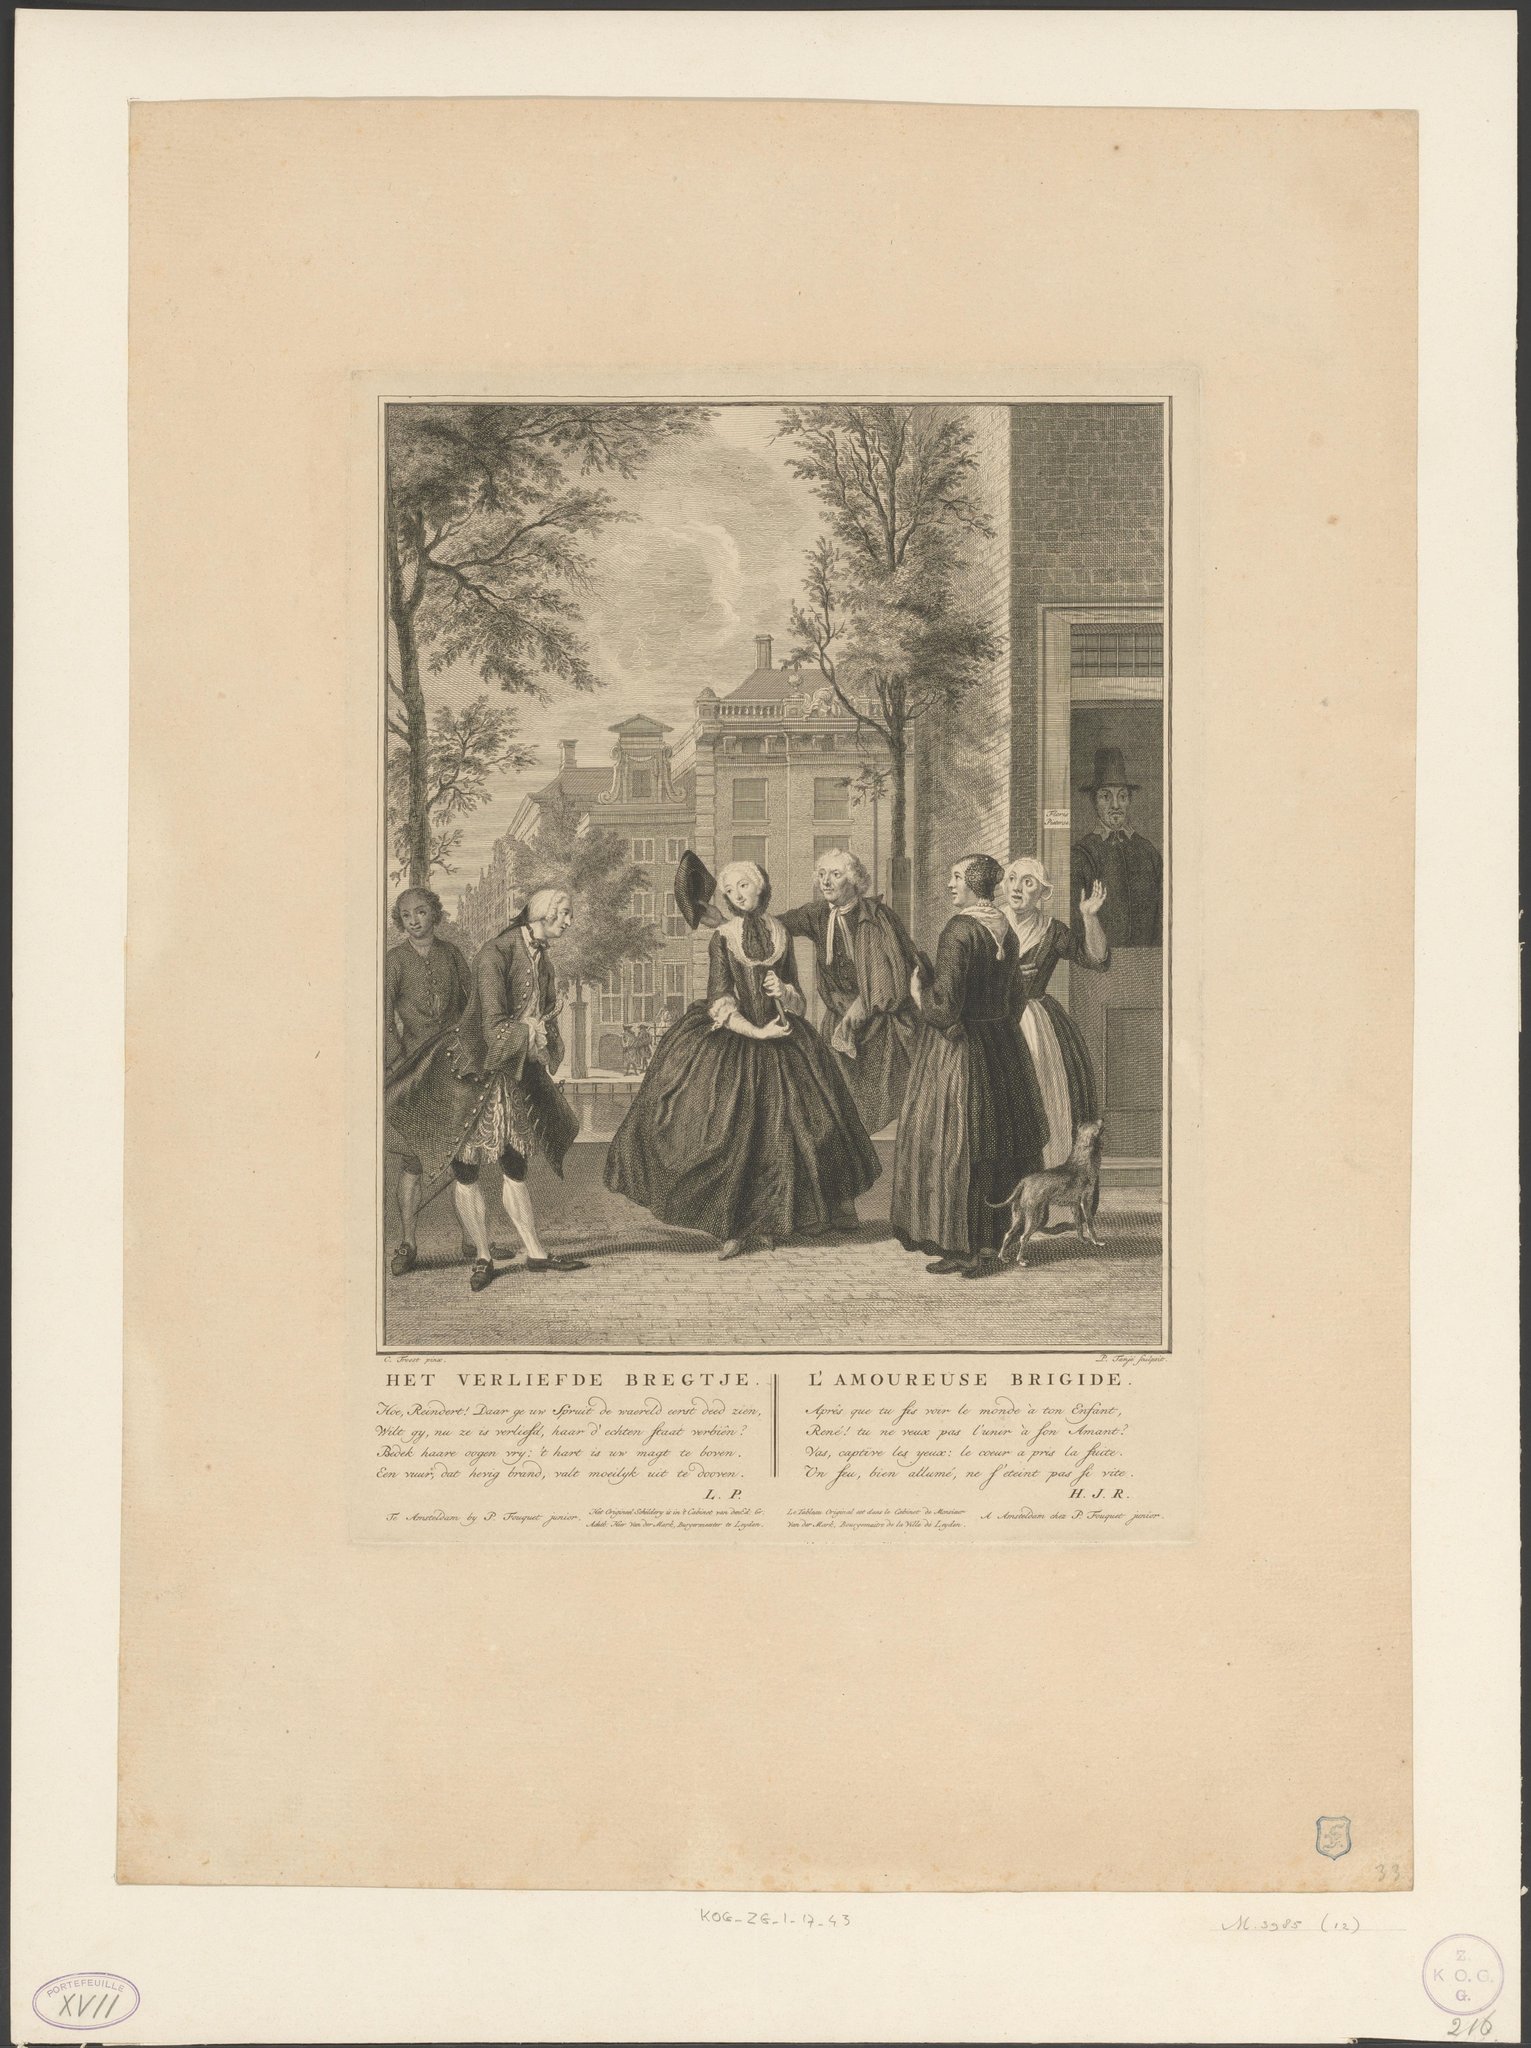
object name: print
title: Het verliefde Bregtje / L'Amoureuse Brigide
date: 1752-1761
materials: paper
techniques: engraving, etching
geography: amsterdam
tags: father and daughter(s) (family group), lovers' meeting, dog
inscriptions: stamp, collector's mark: Lugt 963, collector's mark: Lugt 1641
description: Brechje ontmoet op straat haar geliefde Robbertus. Haar vader tracht te verhinderen dat zij hem ziet, door zijn hoed voor haar gezicht te houden. Scène uit het toneelstuk Verliefde Brechje, van Pieter Willem Haps. Onderwerpsrubrieken binnen de Atlas Zeden en Gewoonten: Tooneel, Prenten van Cornelis Troost.